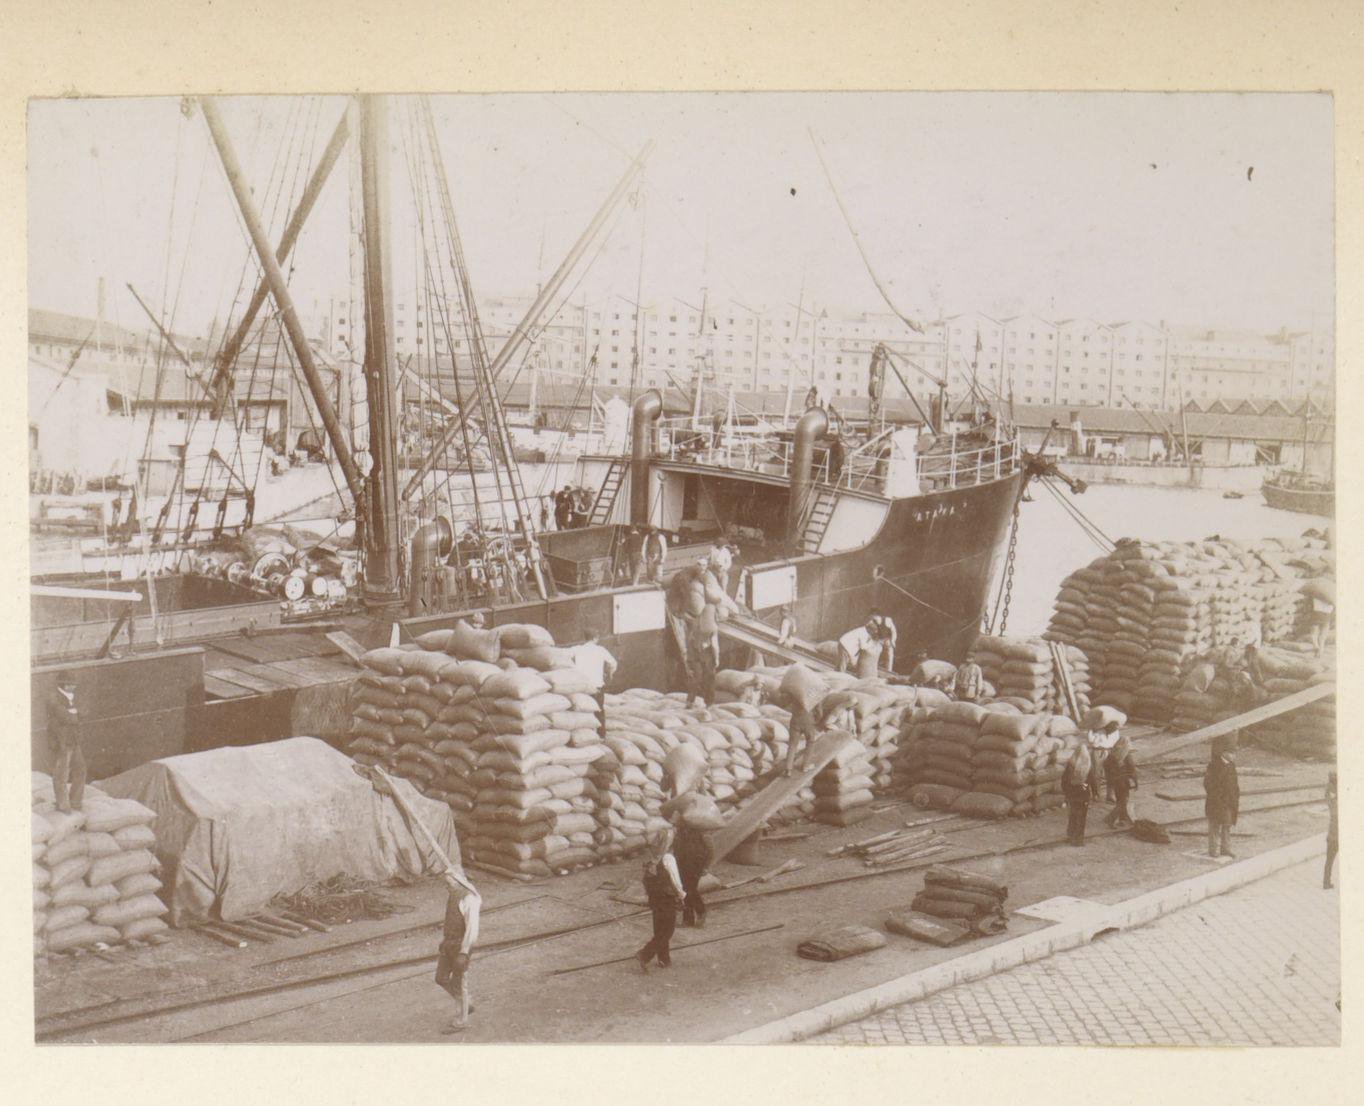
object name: photograph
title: Laad-en loswerkzaamheden bij het schip Ataka, vermoedelijk in de haven van Marseille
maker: Anonymous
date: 1900-1910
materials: paper, photographic support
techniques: daylight paper print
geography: marseille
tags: harbour (+ view ~ vehicle, ship, etc.), quay (+ city(-scape) with figures, staffage), steamship, motorship, marseille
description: Onderdeel van Fotoalbum van een Franse amateurfotograaf met opnames van een familie, distilleerderij Delizy & Doistau Fils, het leger en bezienswaardigheden in Frankrijk.